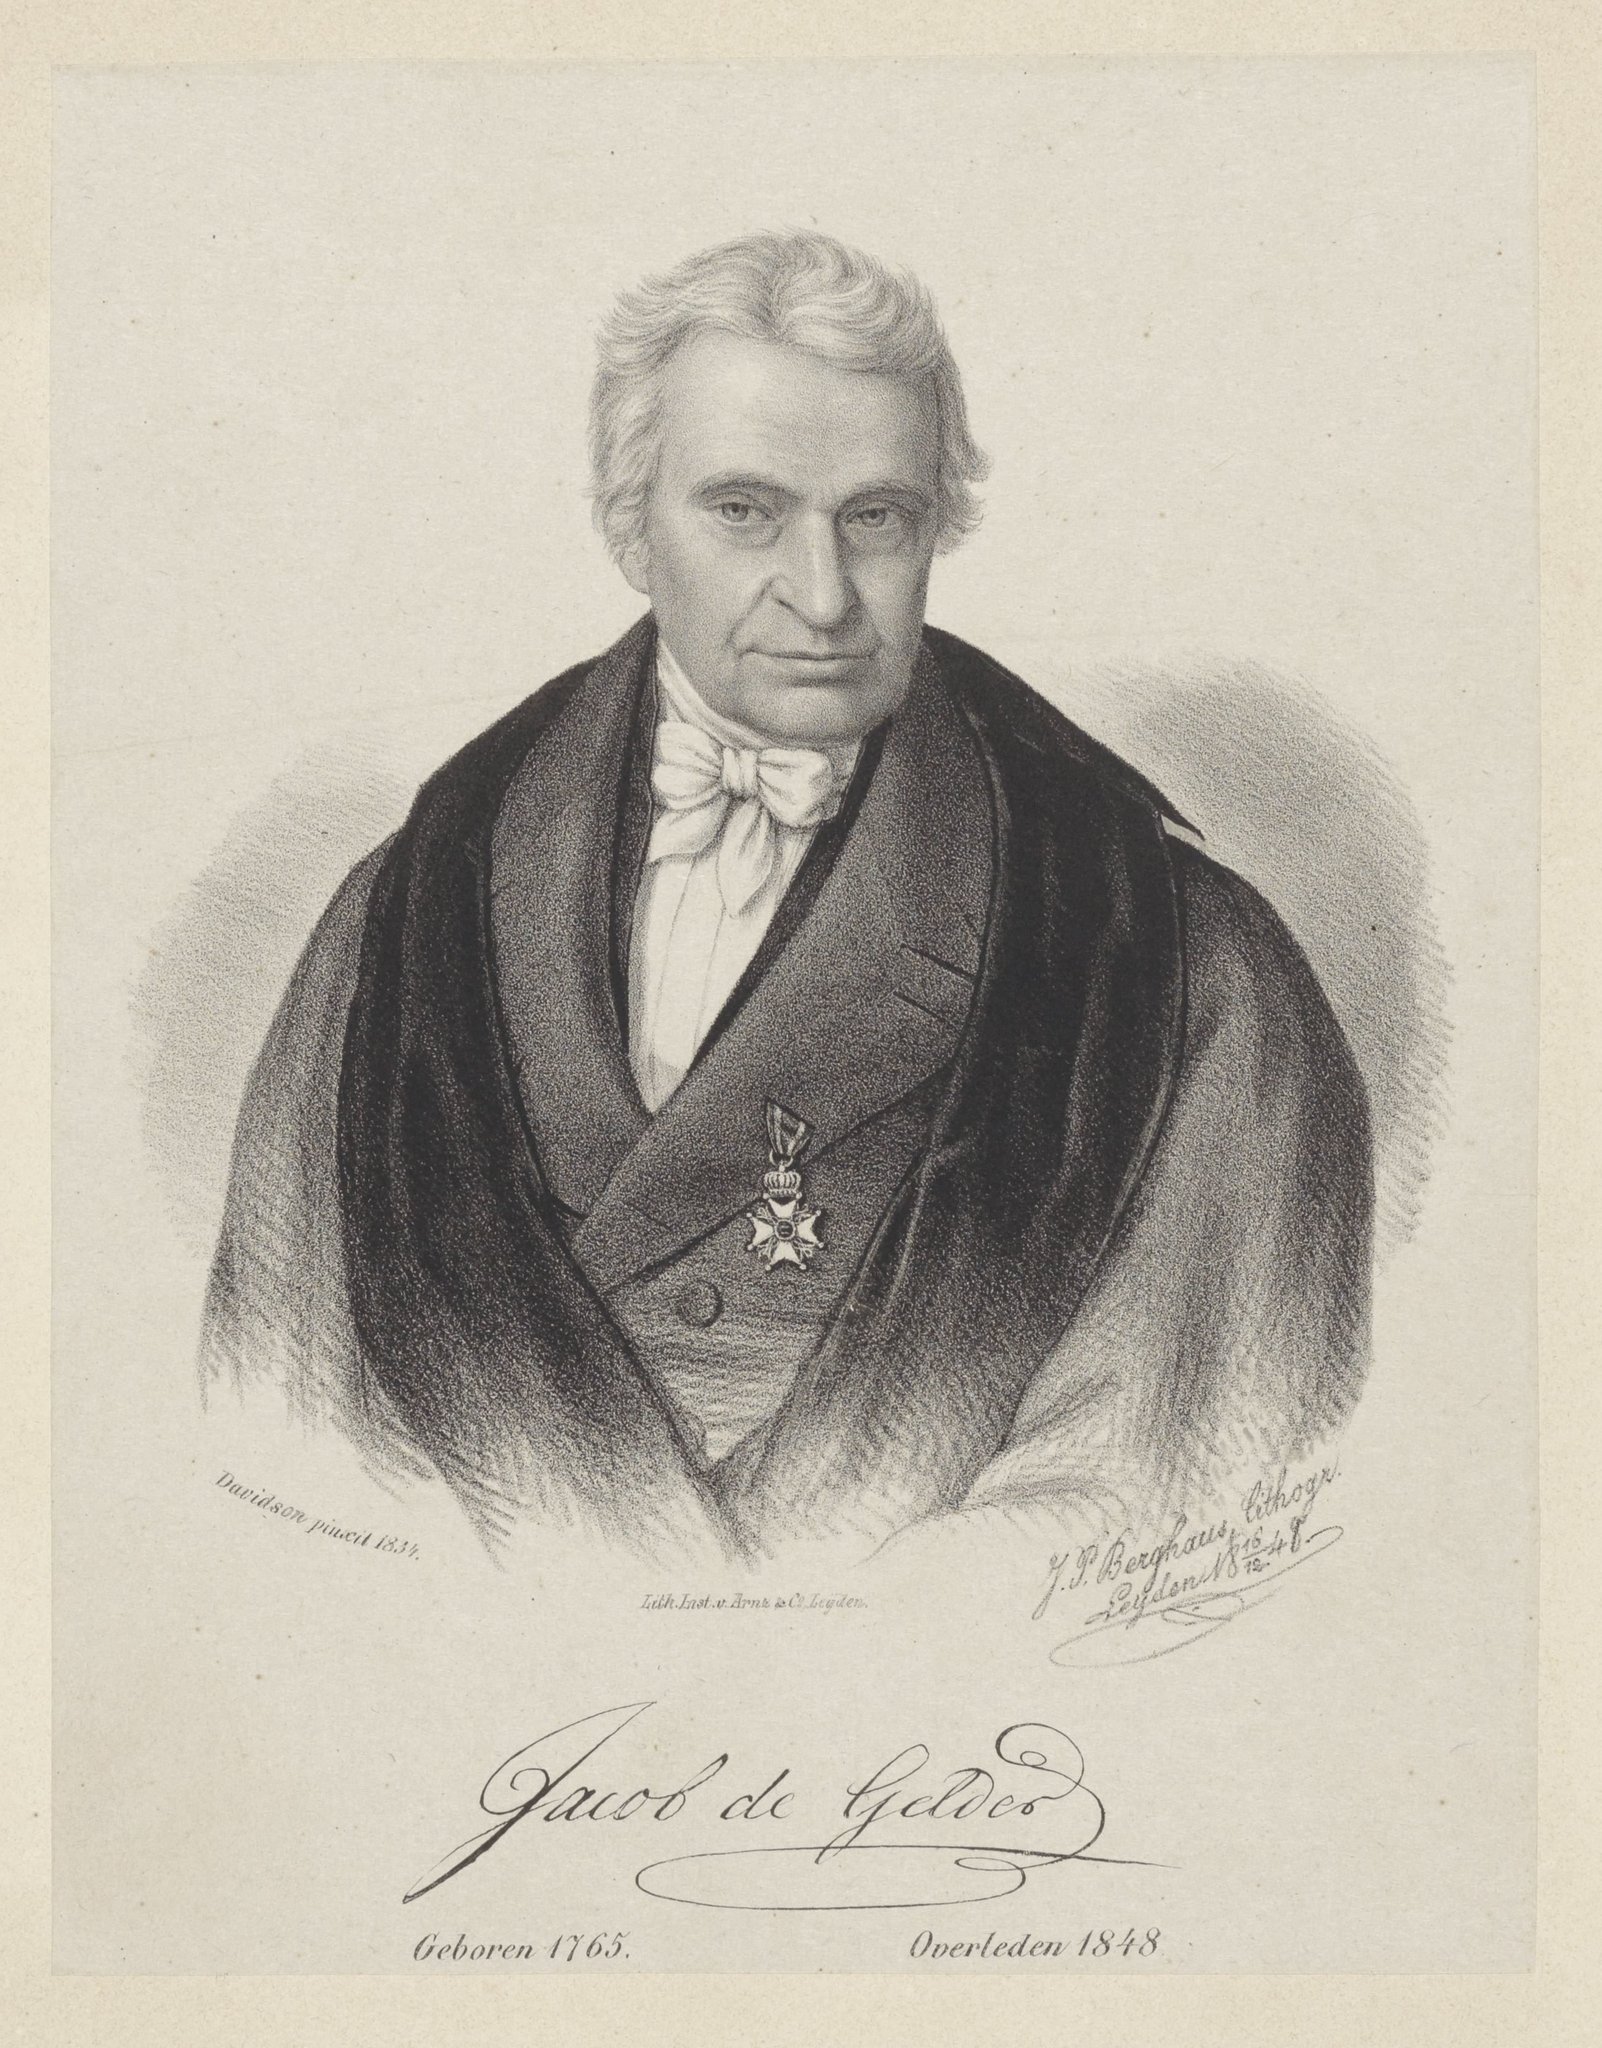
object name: print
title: Portret van Jacob de Gelder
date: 1848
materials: paper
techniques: lithograph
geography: netherlands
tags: knighthood order, historical persons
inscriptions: collector's mark: Lugt 2228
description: De geportretteerde draagt een ridderorde op de borst. Onder het portret zijn signatuur, geboorte- en sterfjaar.